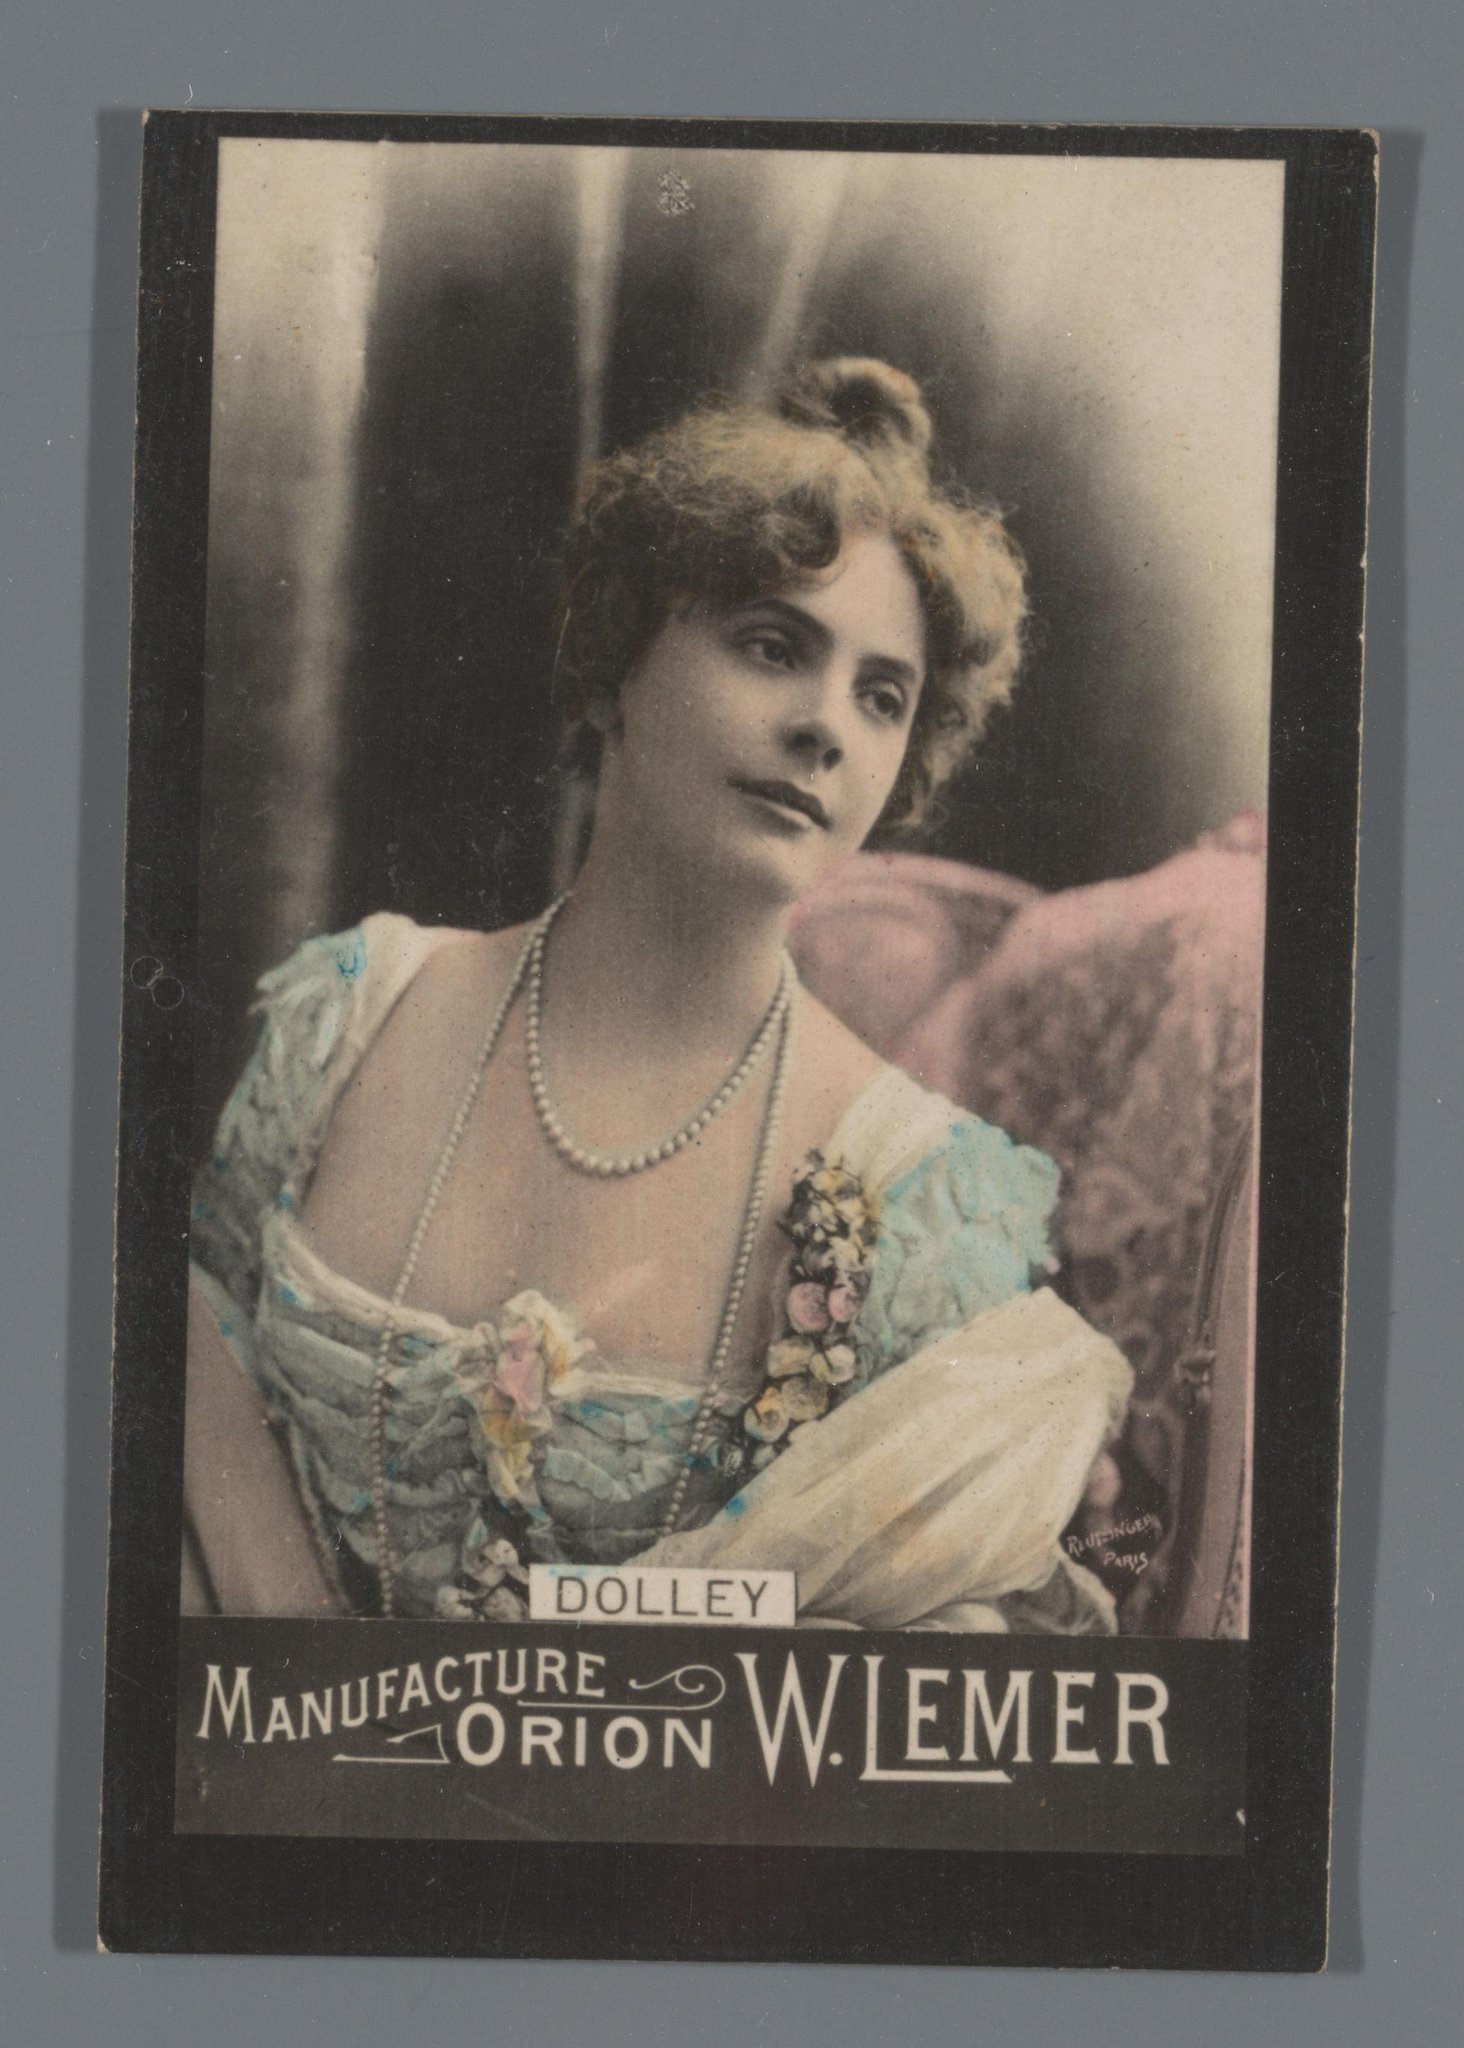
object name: photograph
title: Dolley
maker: léopold reutlinger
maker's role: fotograaf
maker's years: 1863-1937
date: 1895-1910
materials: paper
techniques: gelatin silver print, hand coloring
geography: paris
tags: adult woman, anonymous historical person portrayed, paris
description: Dergelijke foto's stonden bekend als 'zwartjes'. Men verkreeg ze bij aanschaf van bepaalde merken thee, cacao, sigaretten, beschuit, etc. om te verzamelen. Er waren speciaal voor de 'zwartjes' verzamelalbums in omloop.